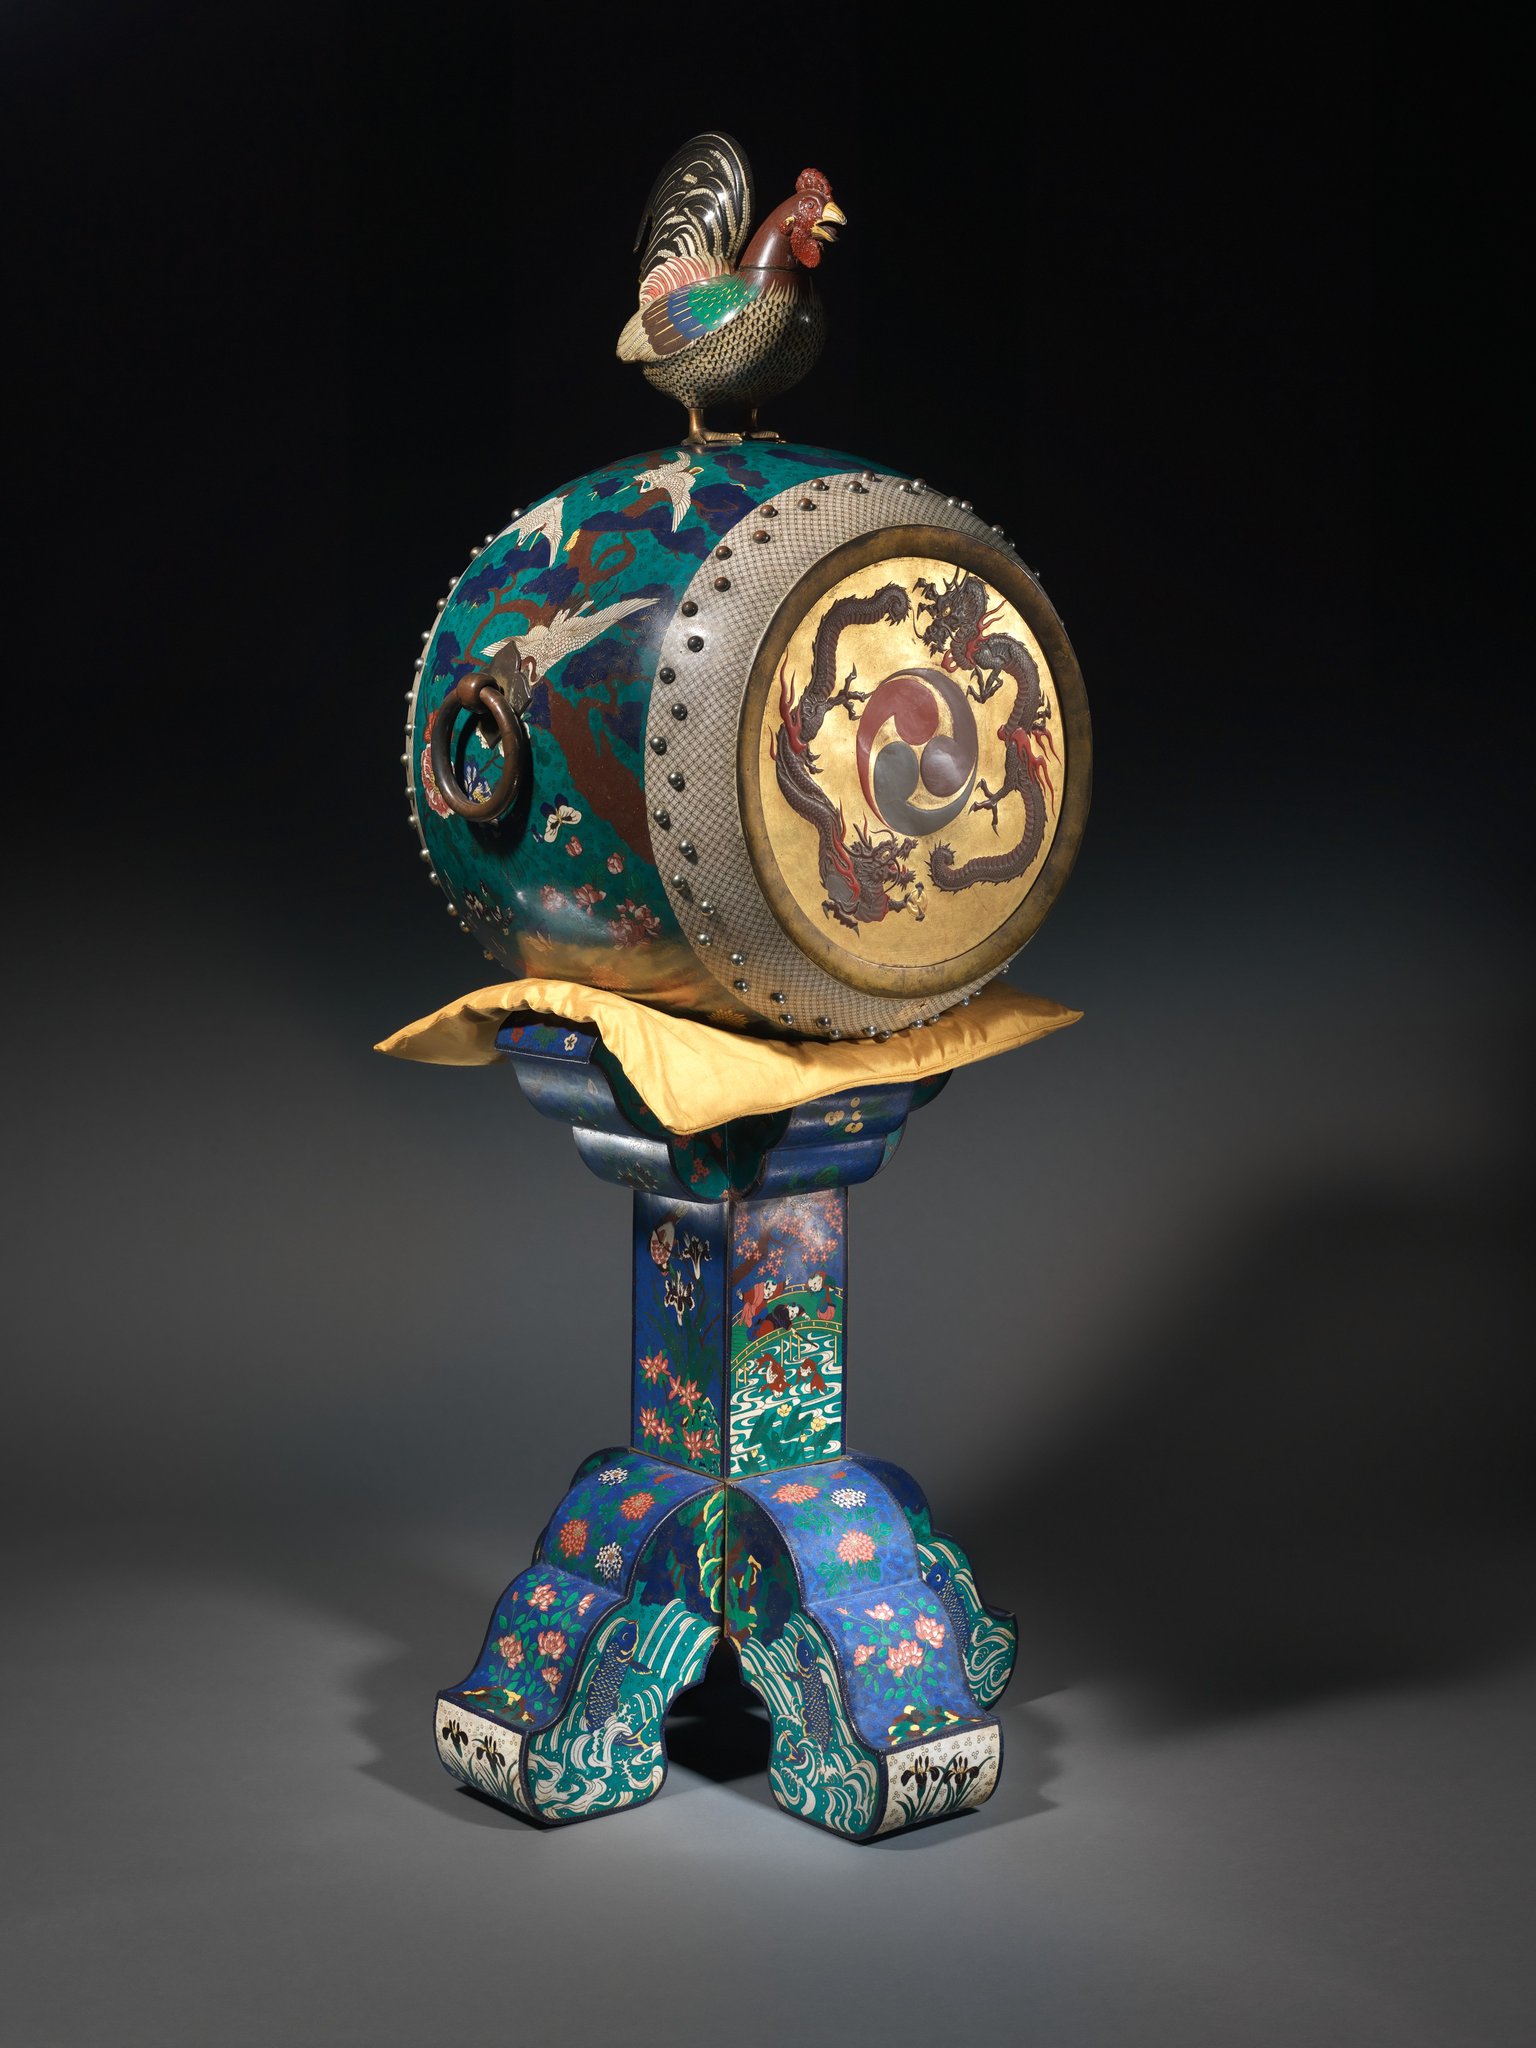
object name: o daiko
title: O-daiko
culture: japanese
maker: kodenji hayashi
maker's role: maker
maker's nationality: japanese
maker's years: 1831-1915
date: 1873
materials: metal, silk, wood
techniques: enamel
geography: japan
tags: cranes,fishing,dragons,roosters,fish